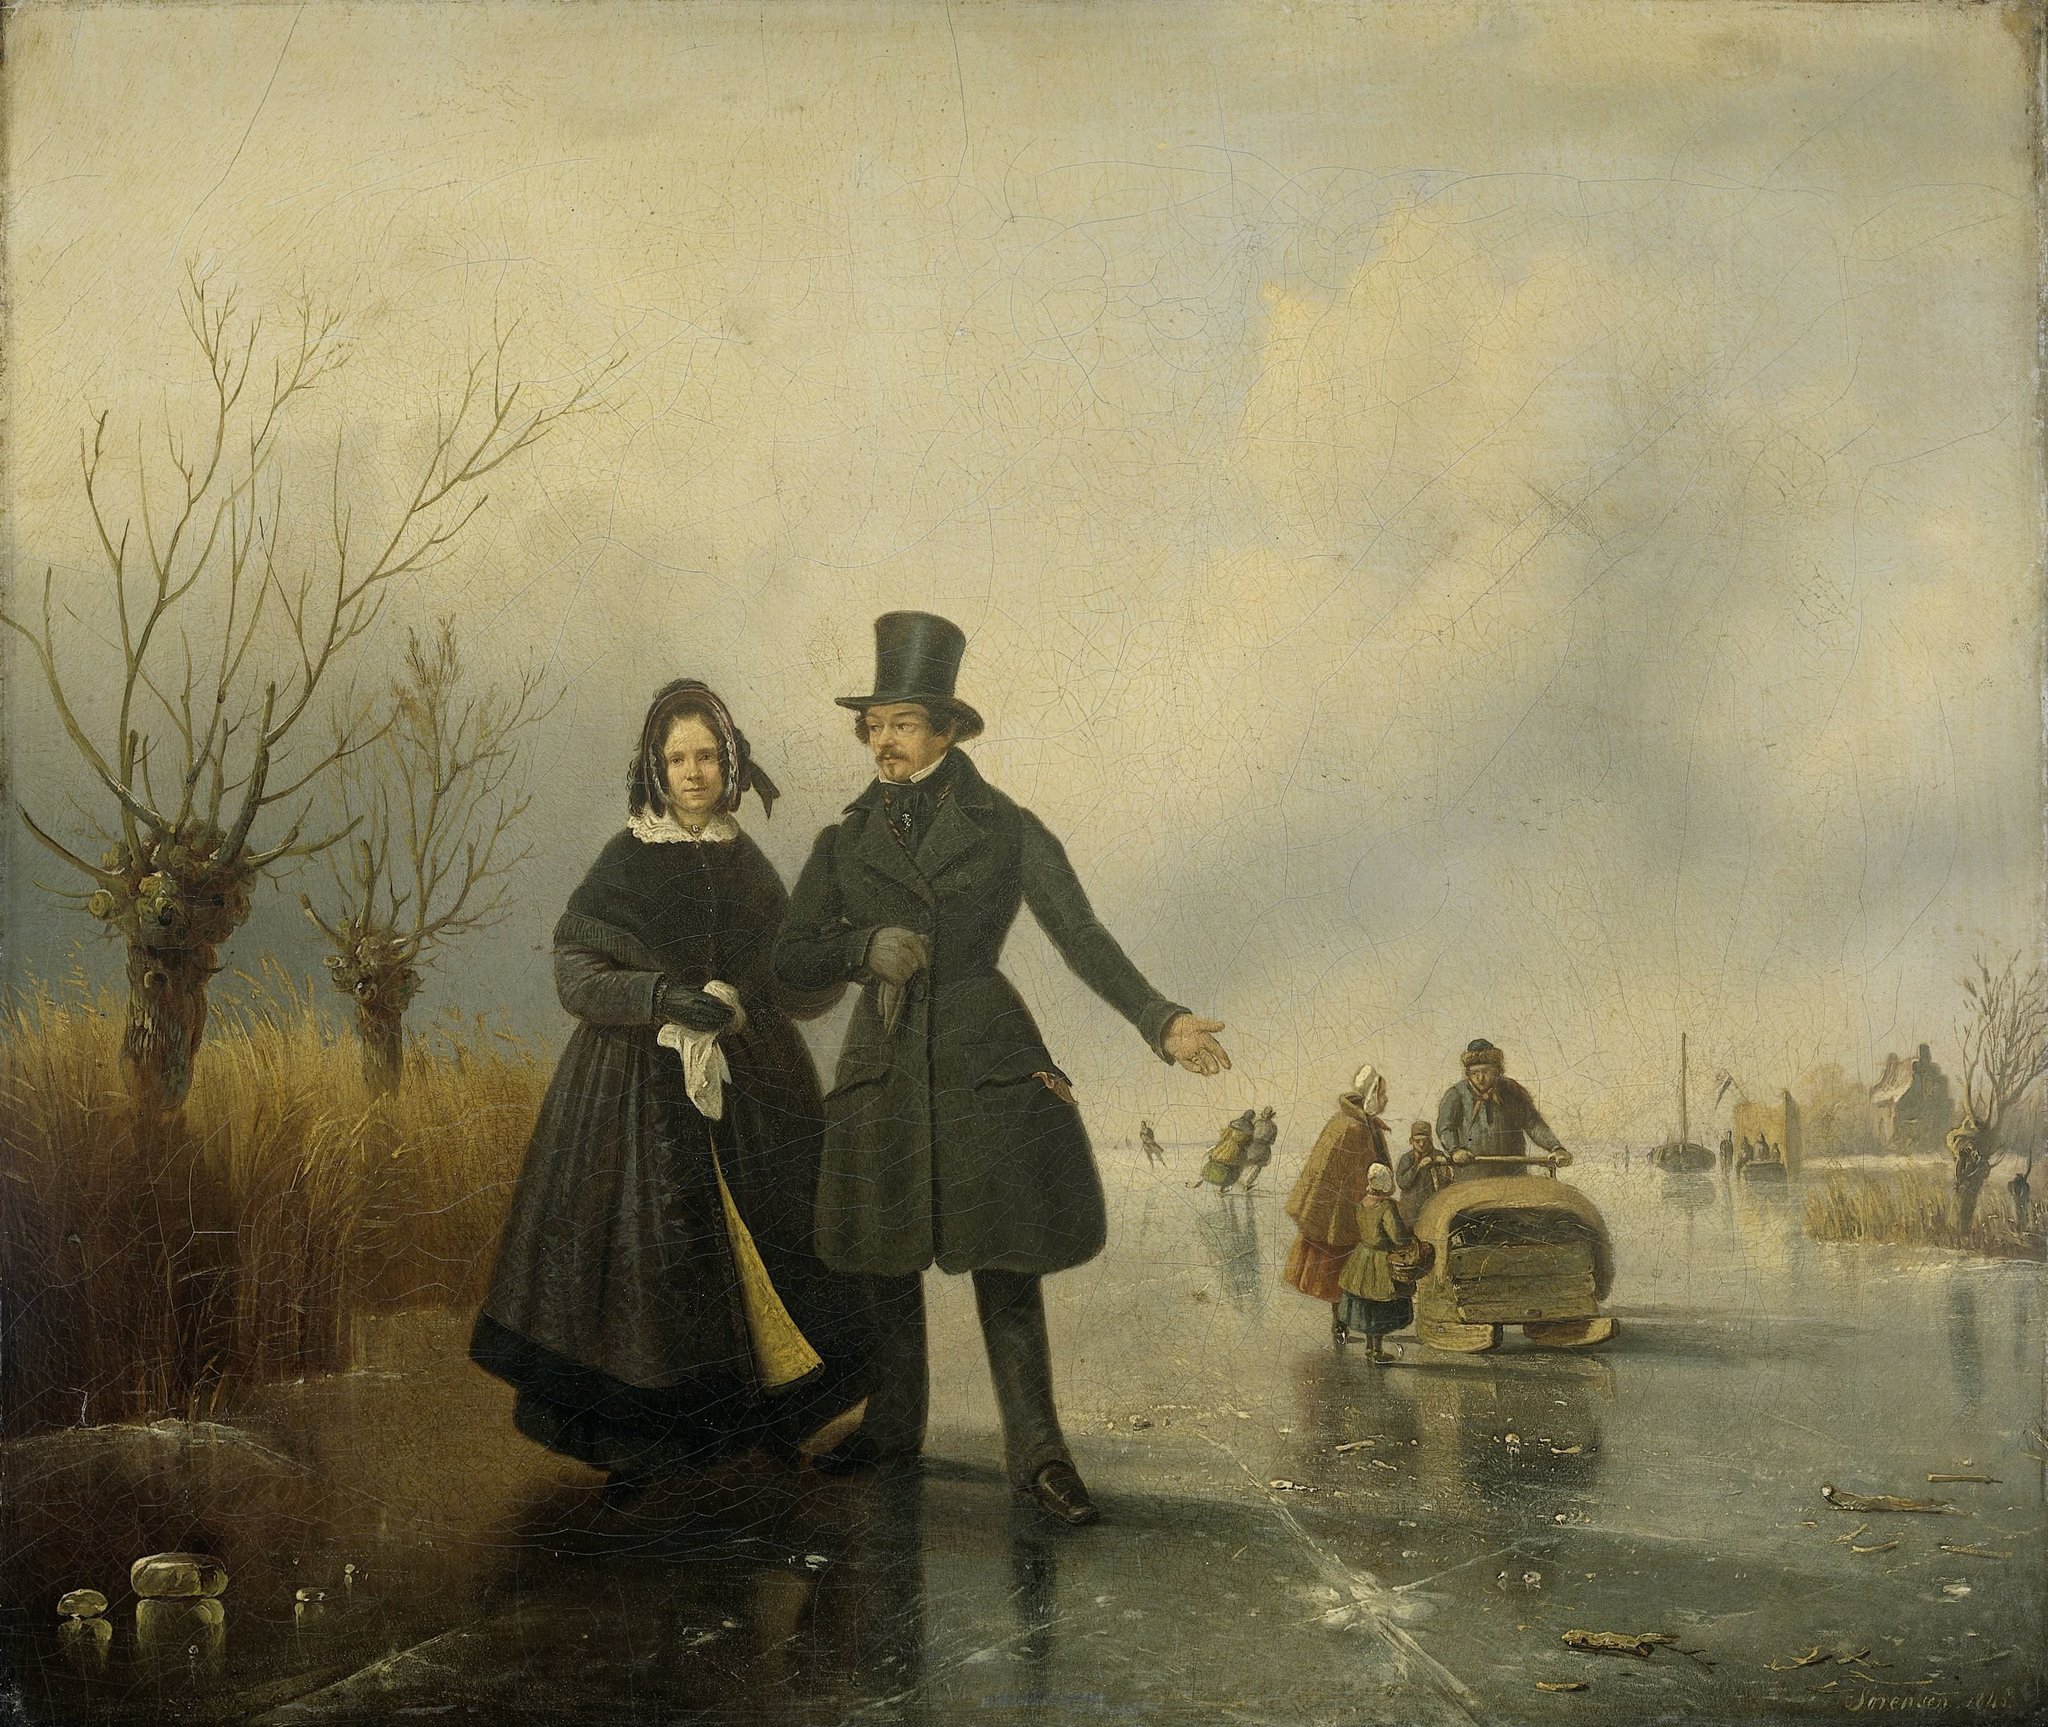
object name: painting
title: Portrait of Mr. and Mrs. Thijssen on the Ice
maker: jacobus sörensen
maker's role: painter, print maker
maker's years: 1812-1857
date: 1845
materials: canvas, oil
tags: marriage, married couple, 'matrimonium', ice ~ freezing weather, small sleigh (winter sports)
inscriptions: signature and date: ‘J. Sorensen 1845’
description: To our knowledge, Mrs and Mr Thijssen are the only individuals in the Netherlands to have had themselves portrayed standing on the ice. This was probably because wealthier citizens considered skating a bit vulgar at the time. Consequently, neither Mr nor Mrs Thijssen are wearing skates. Regrettably, we do not know why they chose such a wintry setting or why Mr Thijssen appears to be gesturing towards other people on the ice.